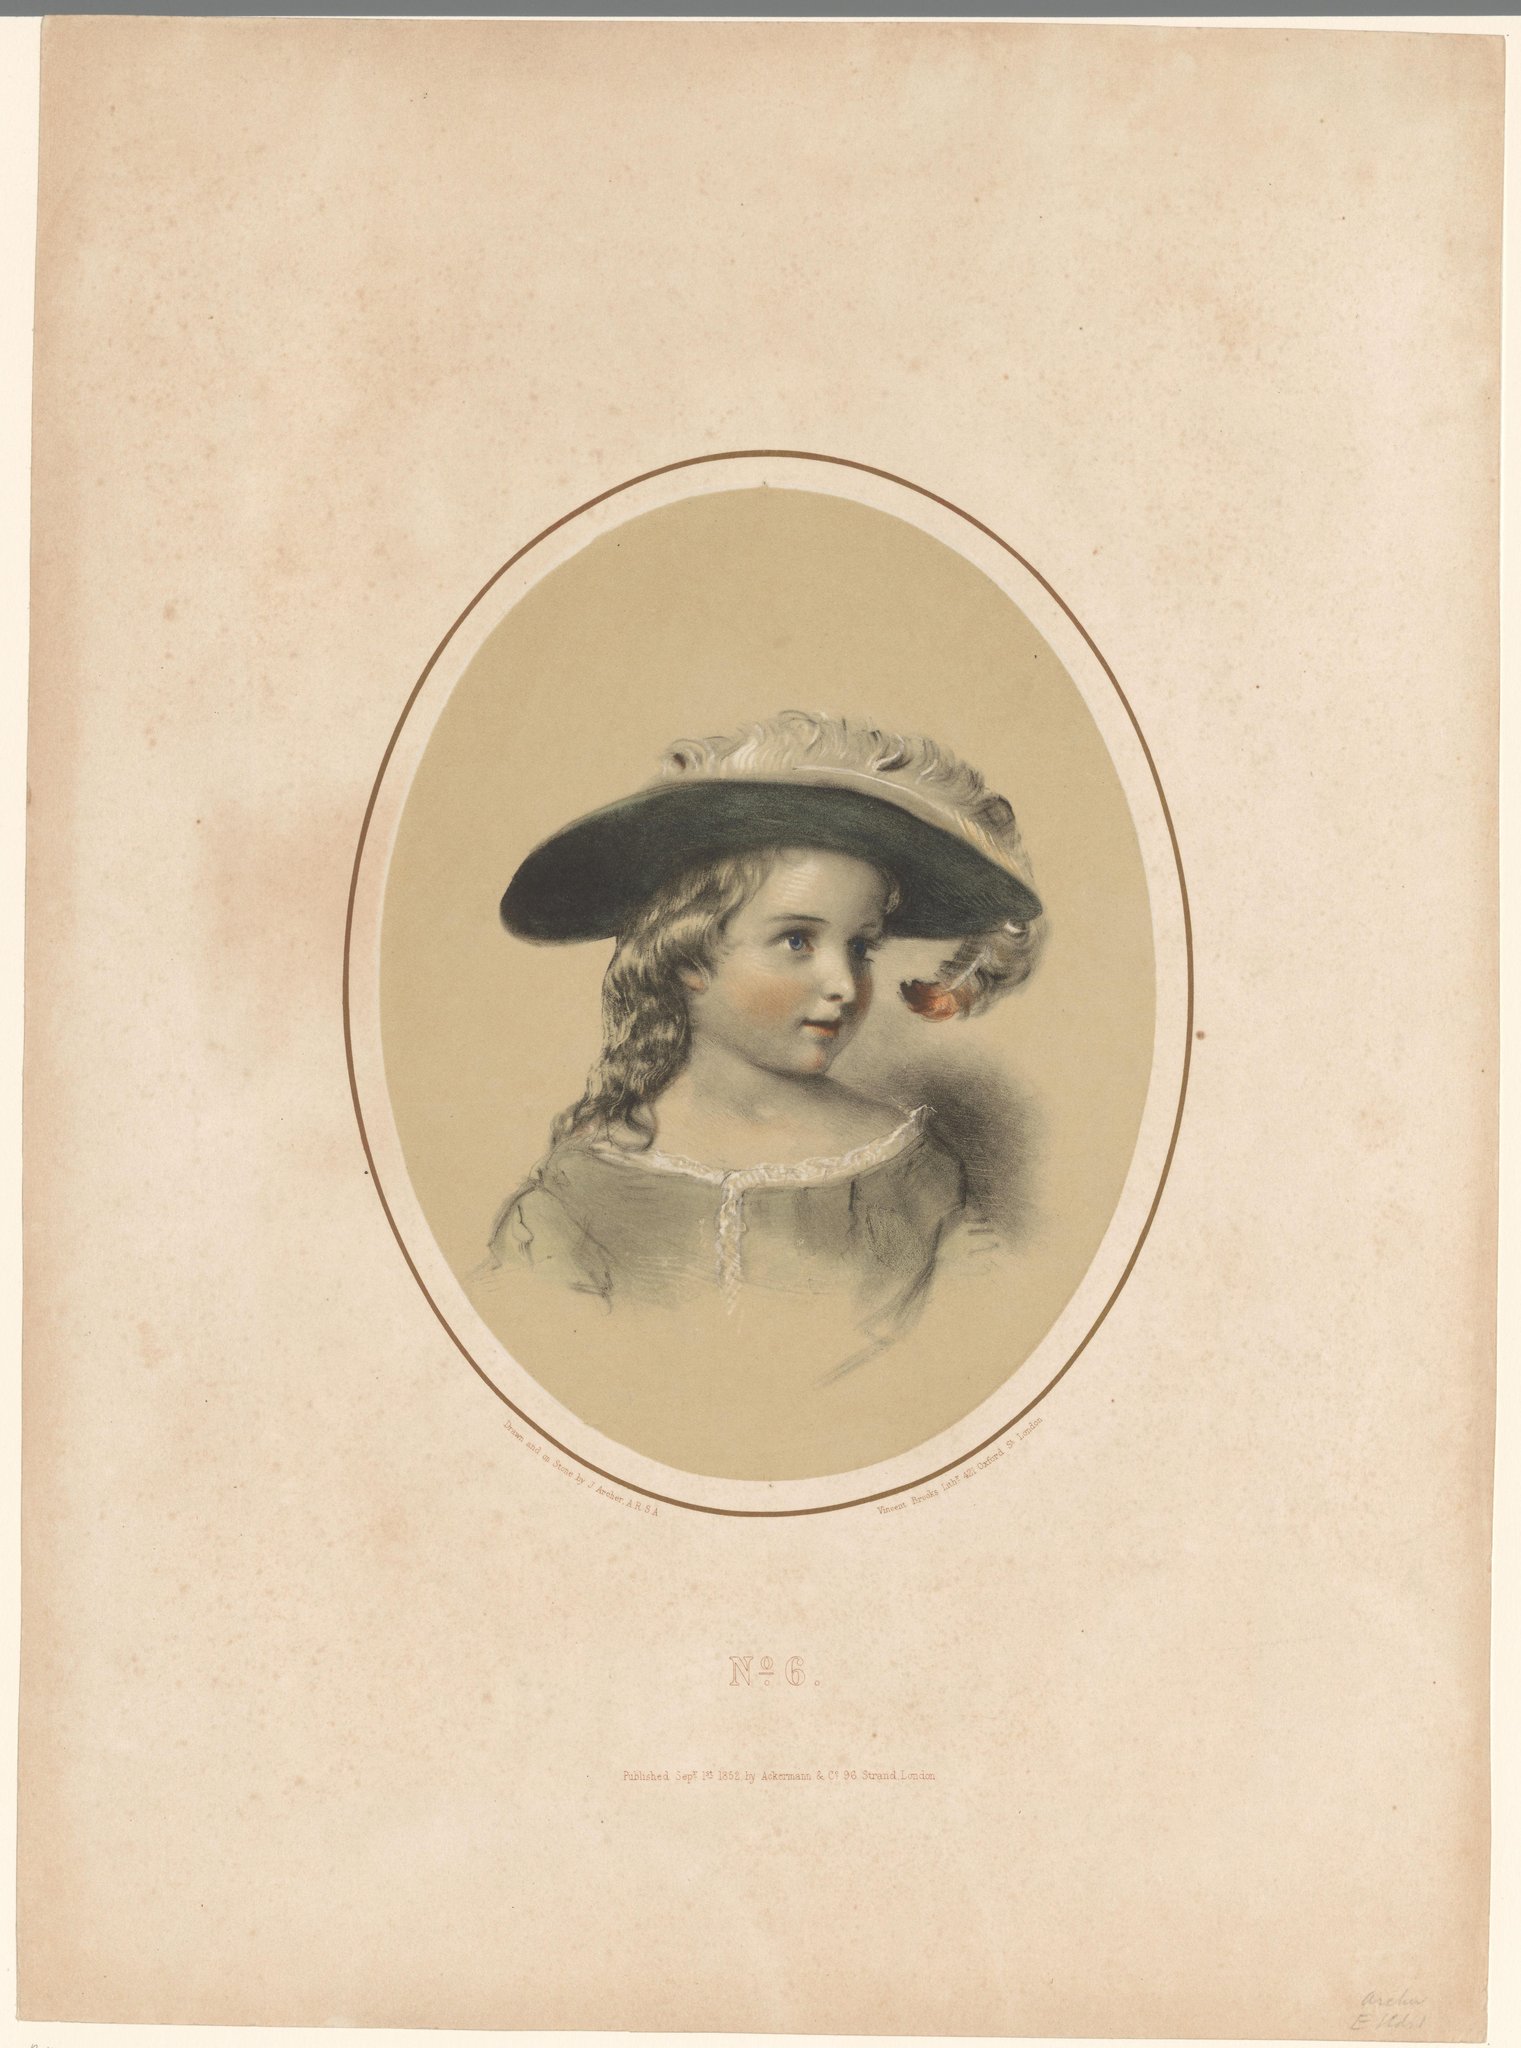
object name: print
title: Portret van een onbekend kind met hoed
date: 1852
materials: paper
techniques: lithograph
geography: london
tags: head-gear, child, historical persons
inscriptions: collector's mark